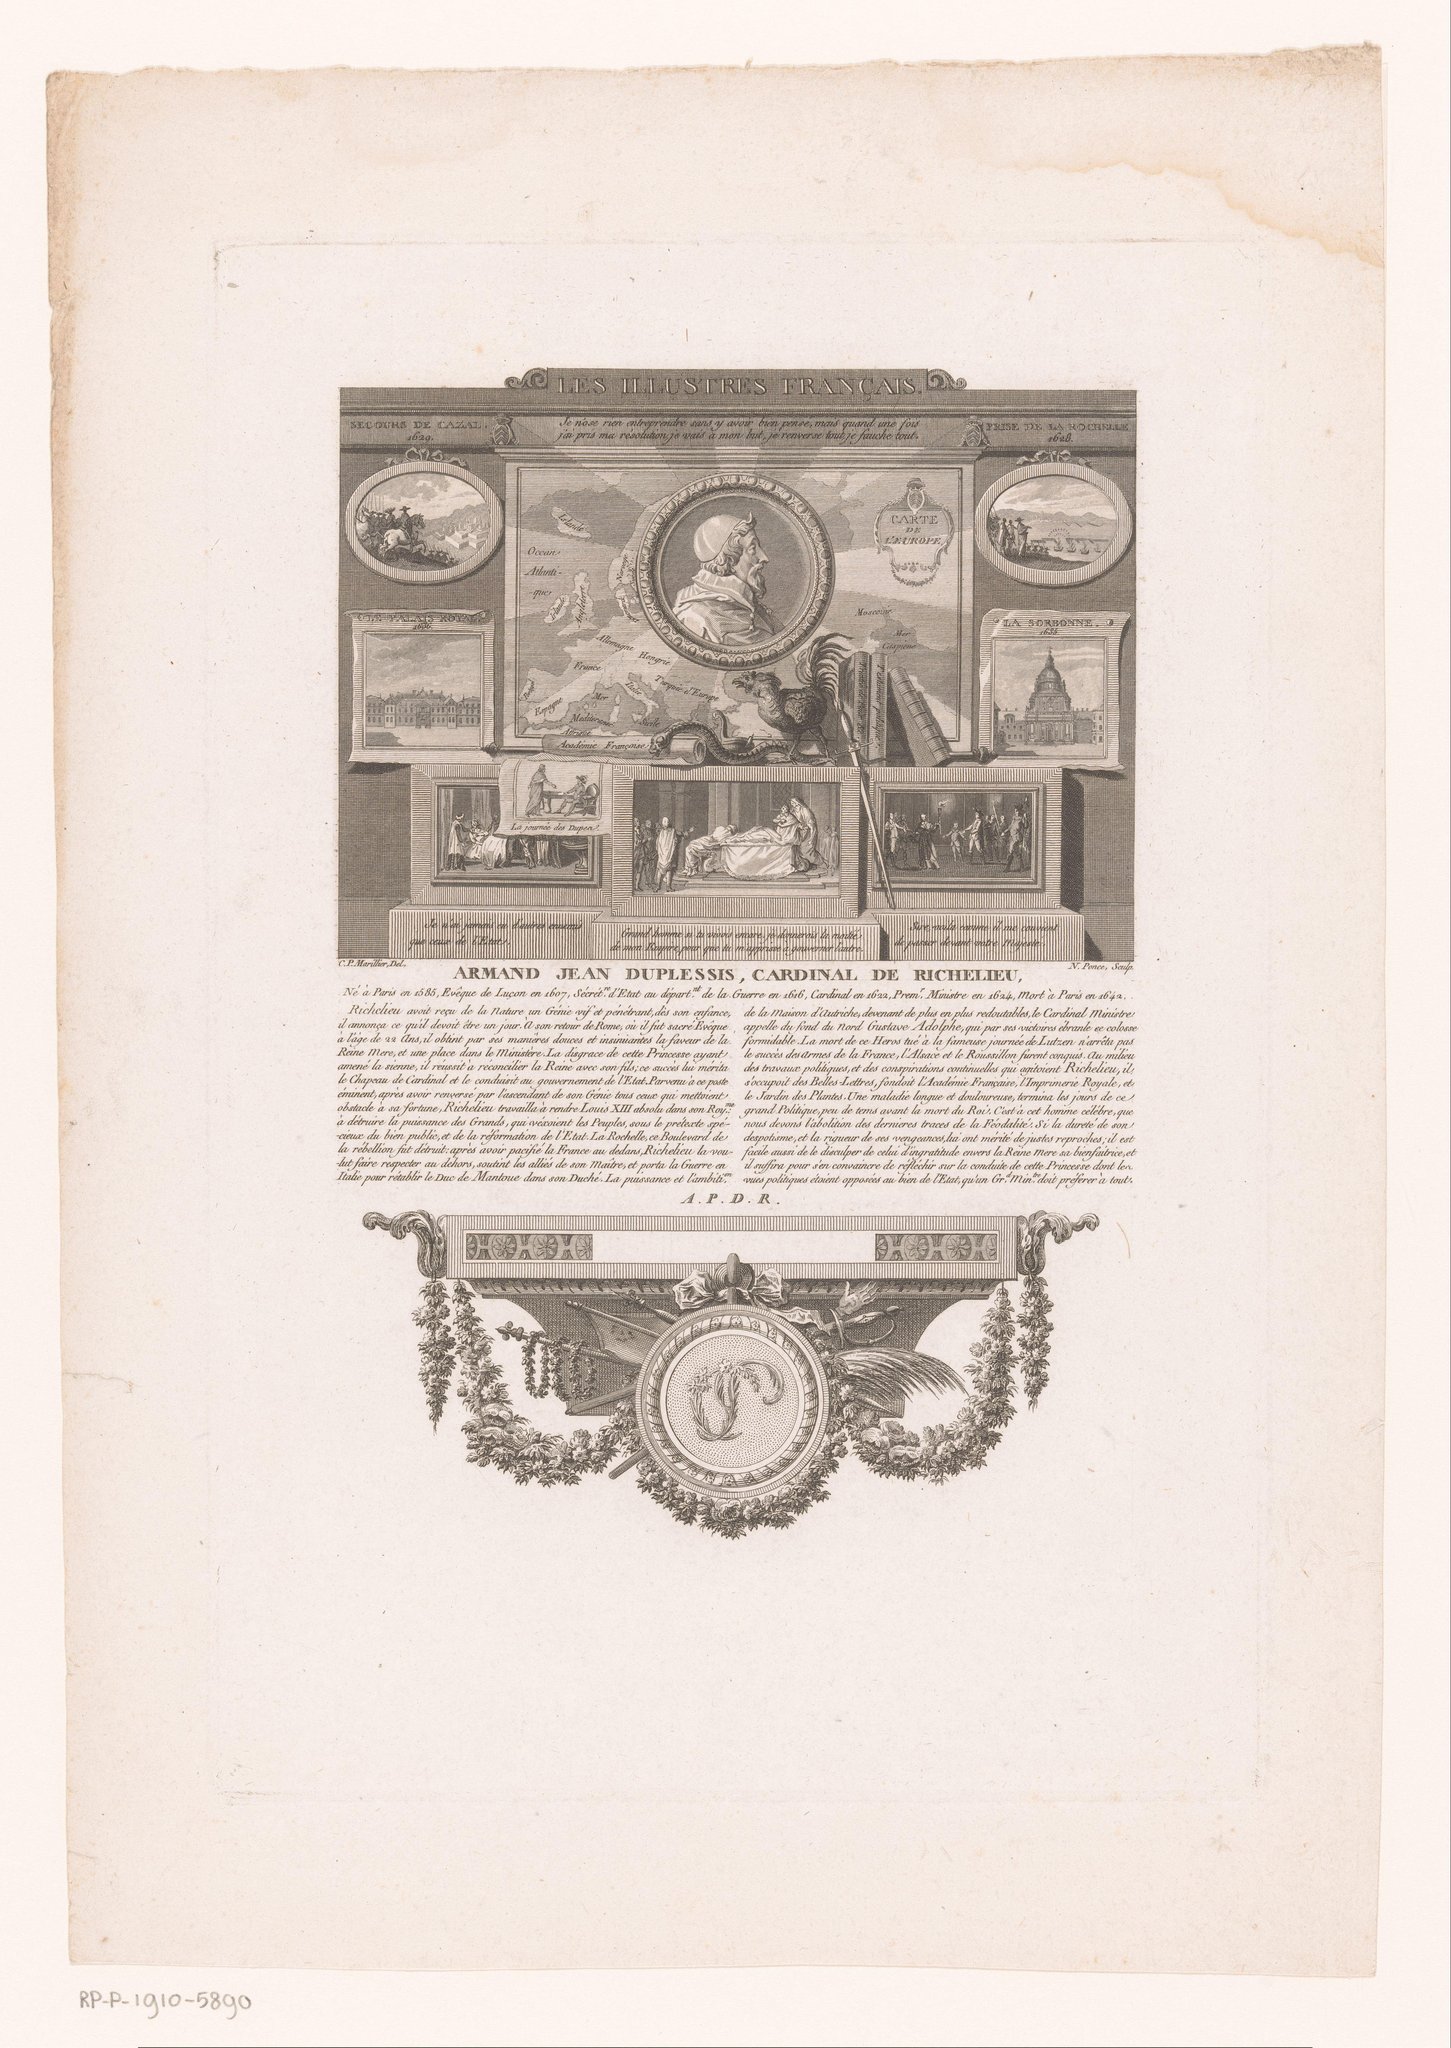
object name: print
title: Portretten van Franse historische figuren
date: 1790-1816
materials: paper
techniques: engraving, etching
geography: france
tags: paris, armand-jean du plessis hertog van richelieu, cardinal, historical persons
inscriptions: collector's mark: Lugt 2228